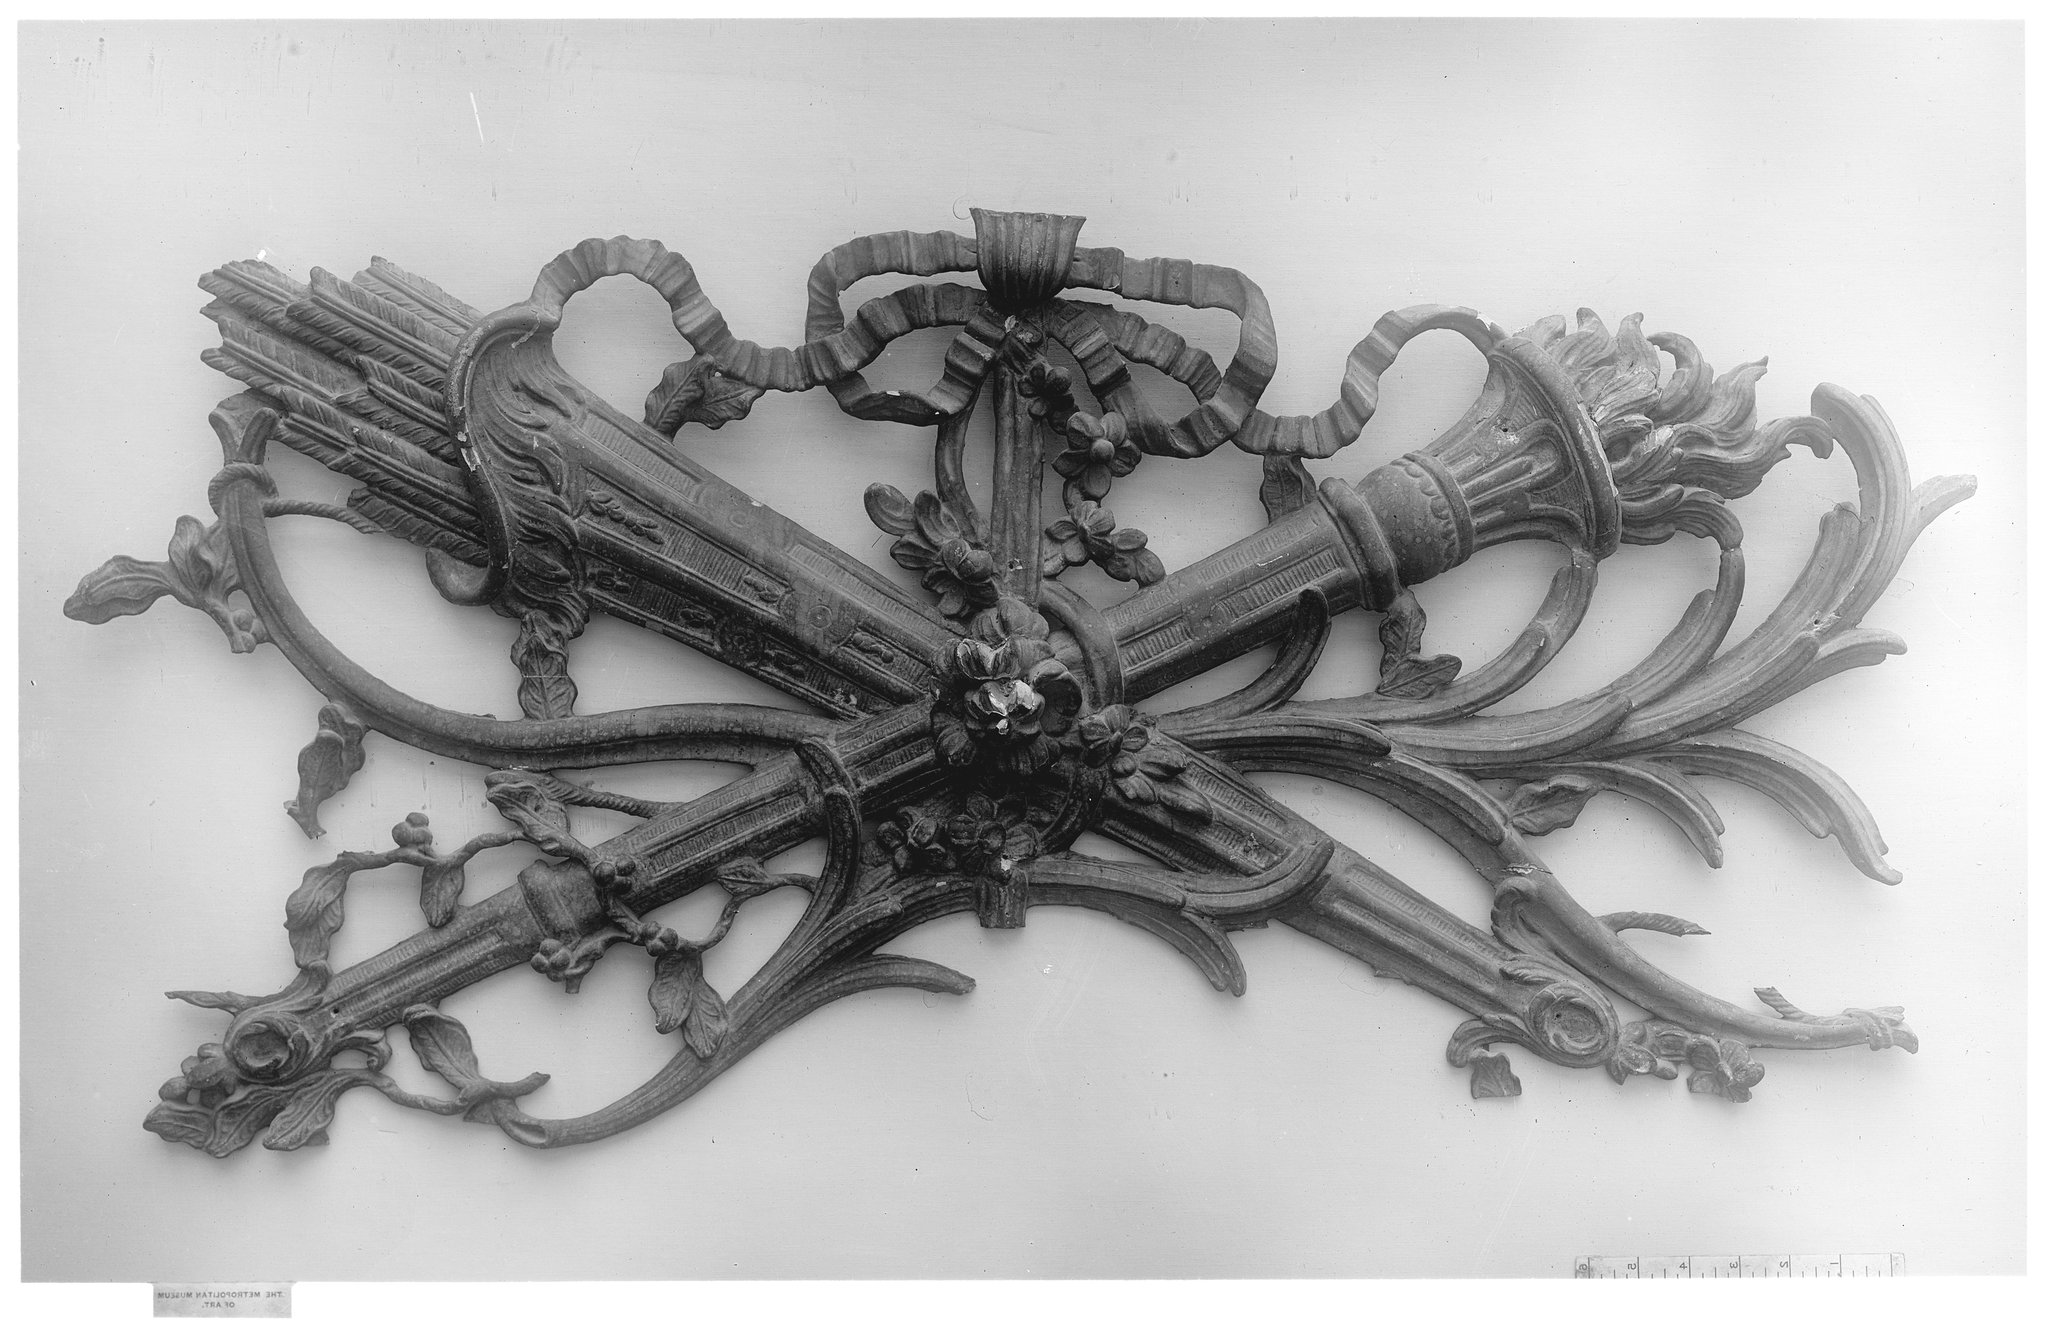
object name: trophy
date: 1701-1800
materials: wood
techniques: carving, gilding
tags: trophies